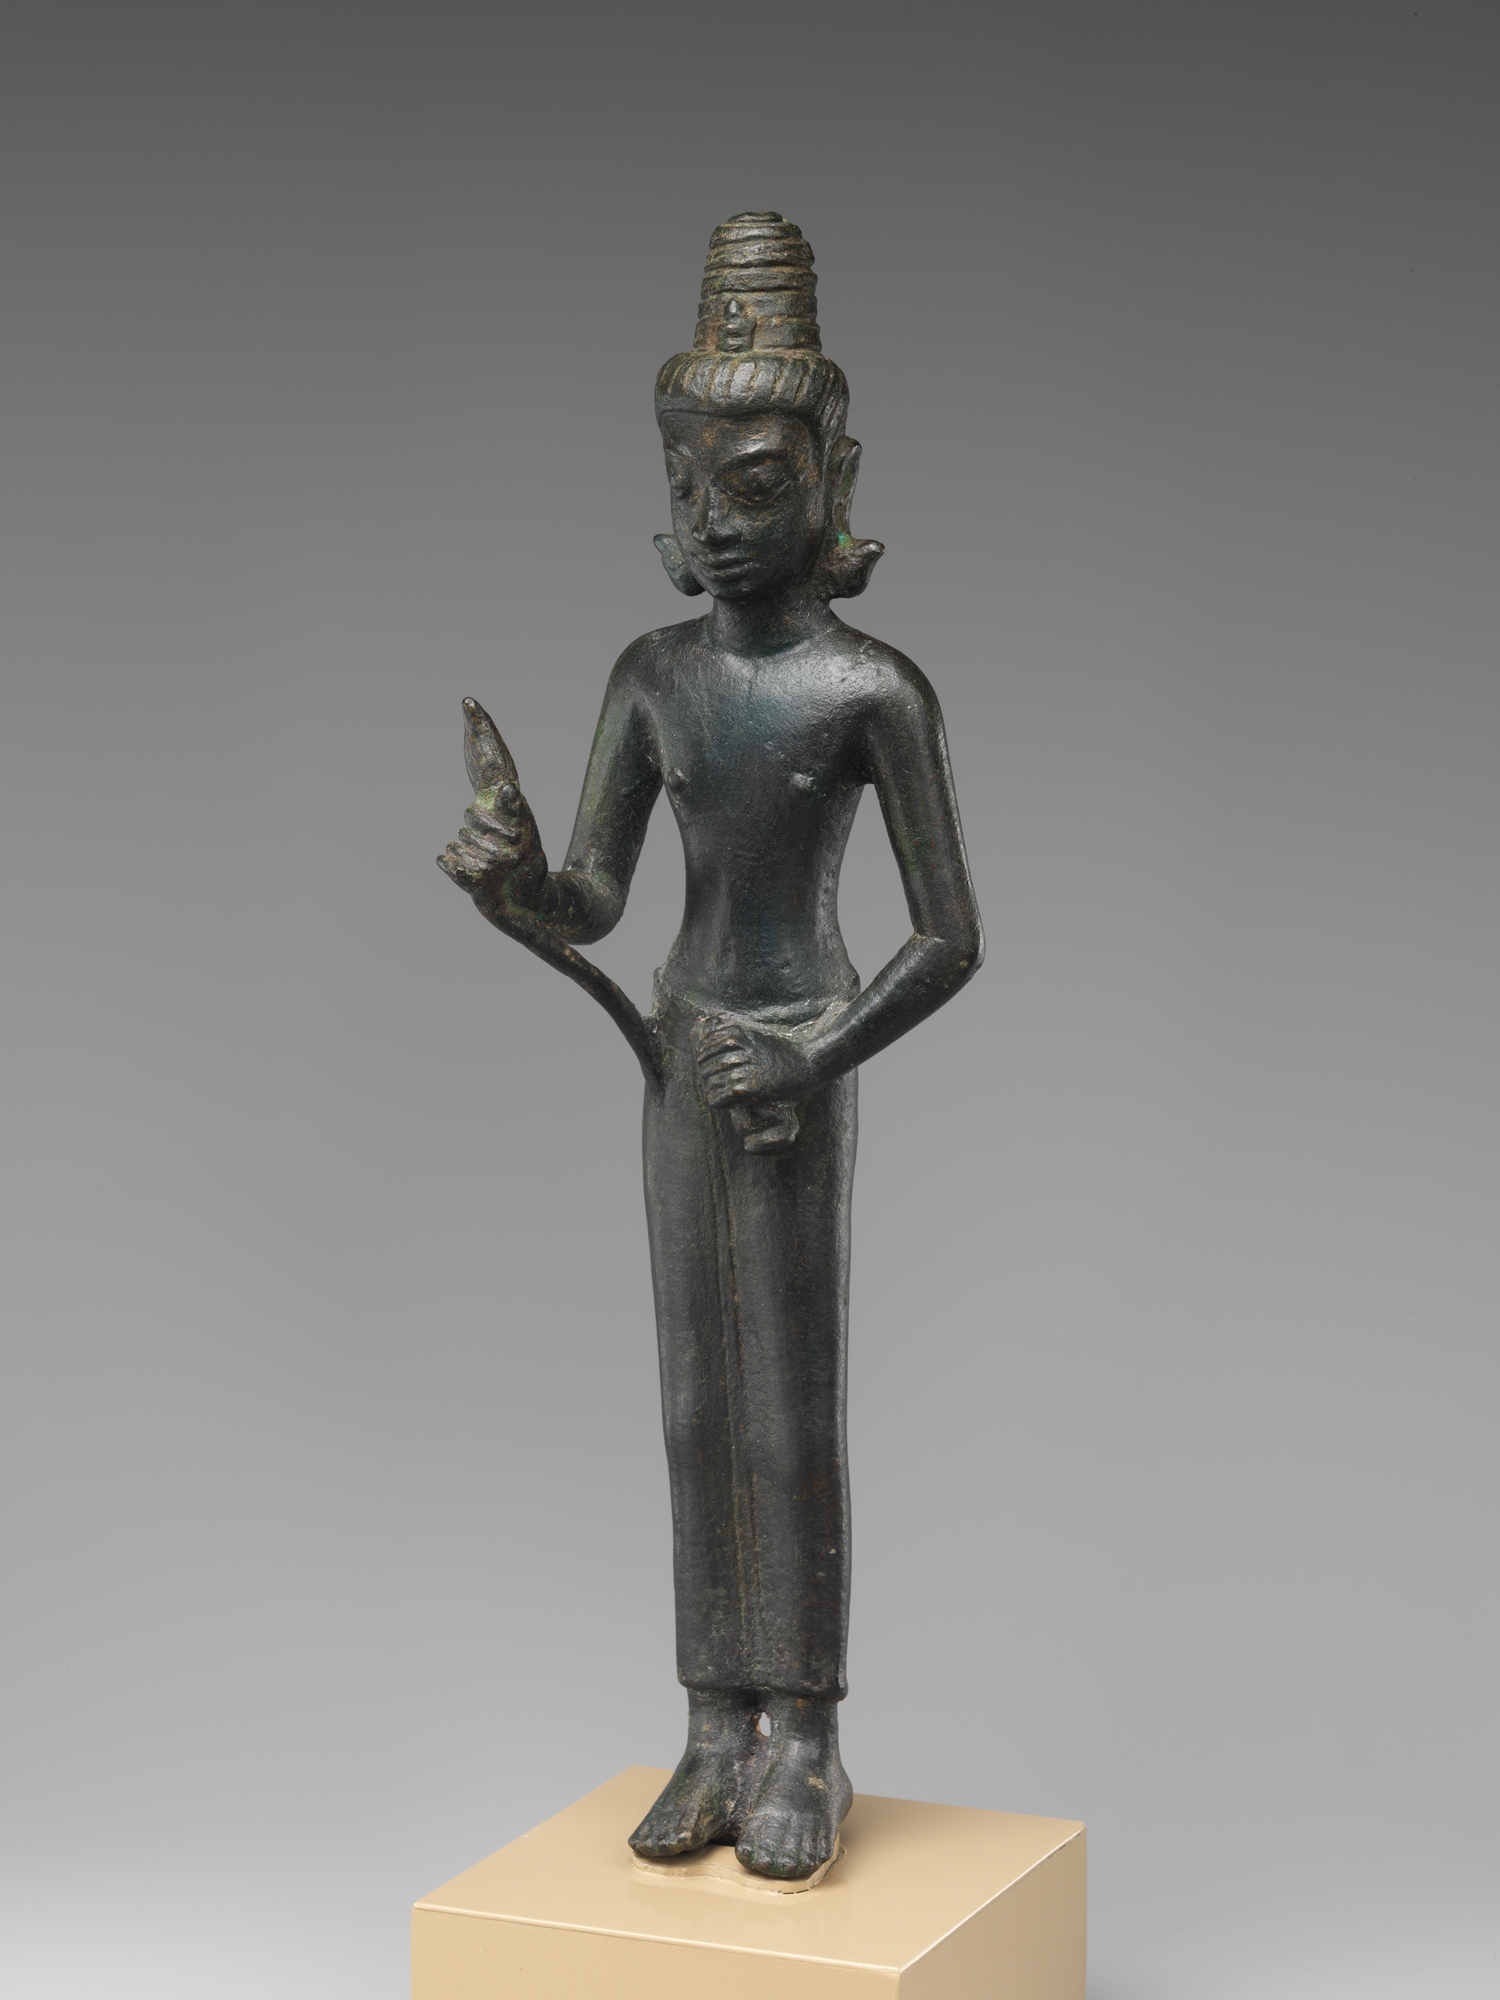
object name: figure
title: Standing Bodhisattva Maitreya , the Buddha of the Future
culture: northeast thai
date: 601-800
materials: bronze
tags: buddhism,bodhisattvas,maitreya